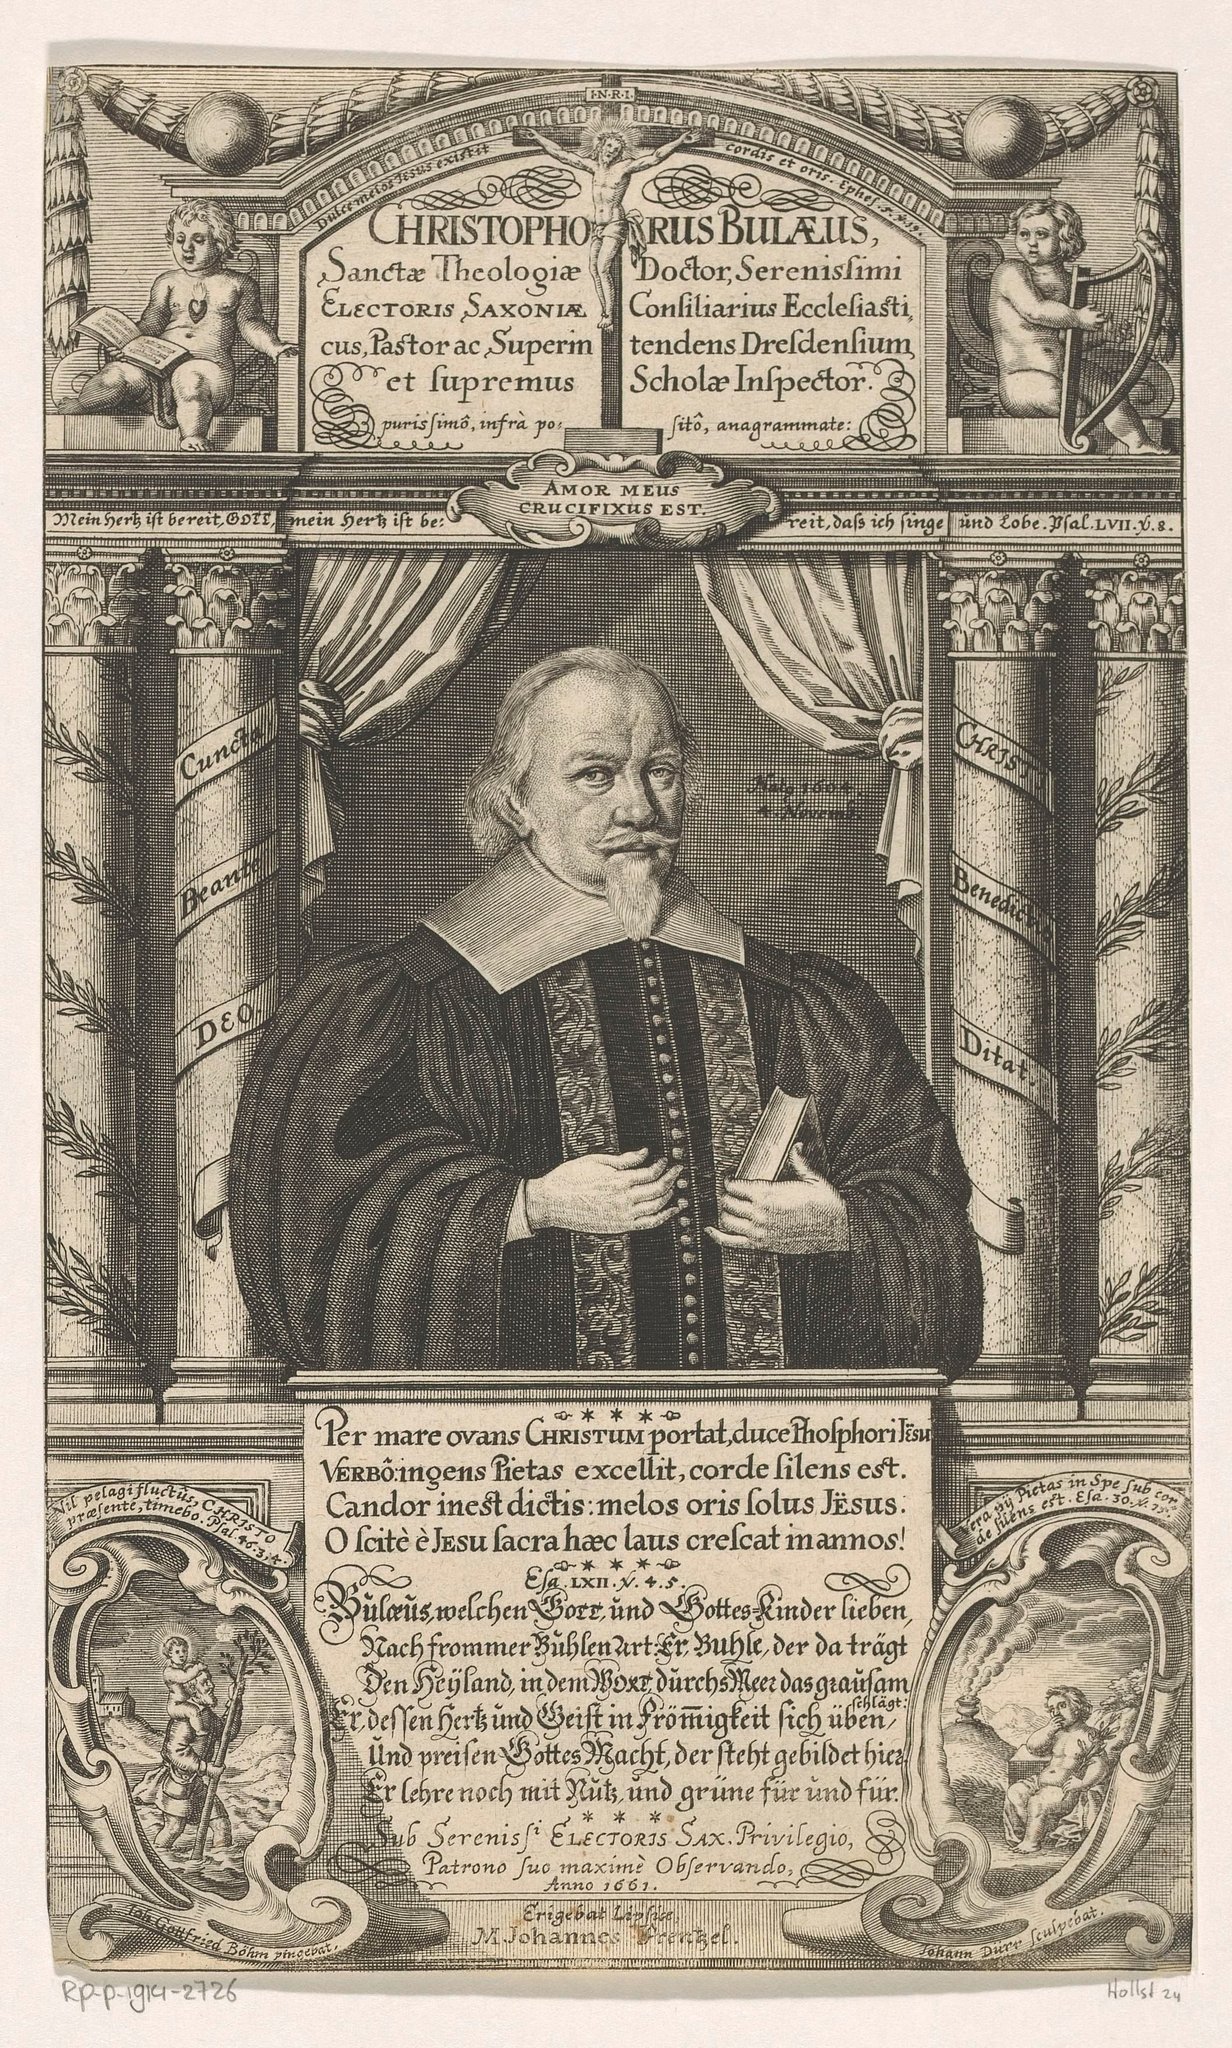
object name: print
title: Portret van Christoph Bulaeus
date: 1661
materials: paper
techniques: engraving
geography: leipzig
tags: 'pietas'; 'pietà' (ripa), cross as symbol of christ, historical persons, ornament ~ cartouche, ornament ~ festoon, garland, cupids: 'amores', 'amoretti', 'putti', the giant and martyr christophorus; possible attributes: palm-tree (with bunches of dates, or withered), infant christ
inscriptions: collector's mark: Lugt 2228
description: Portret in architecturale omlijsting, met lofdicht in het Latijn onderaan. Rechts- en linksonder een medaillon met iconografisch motto.